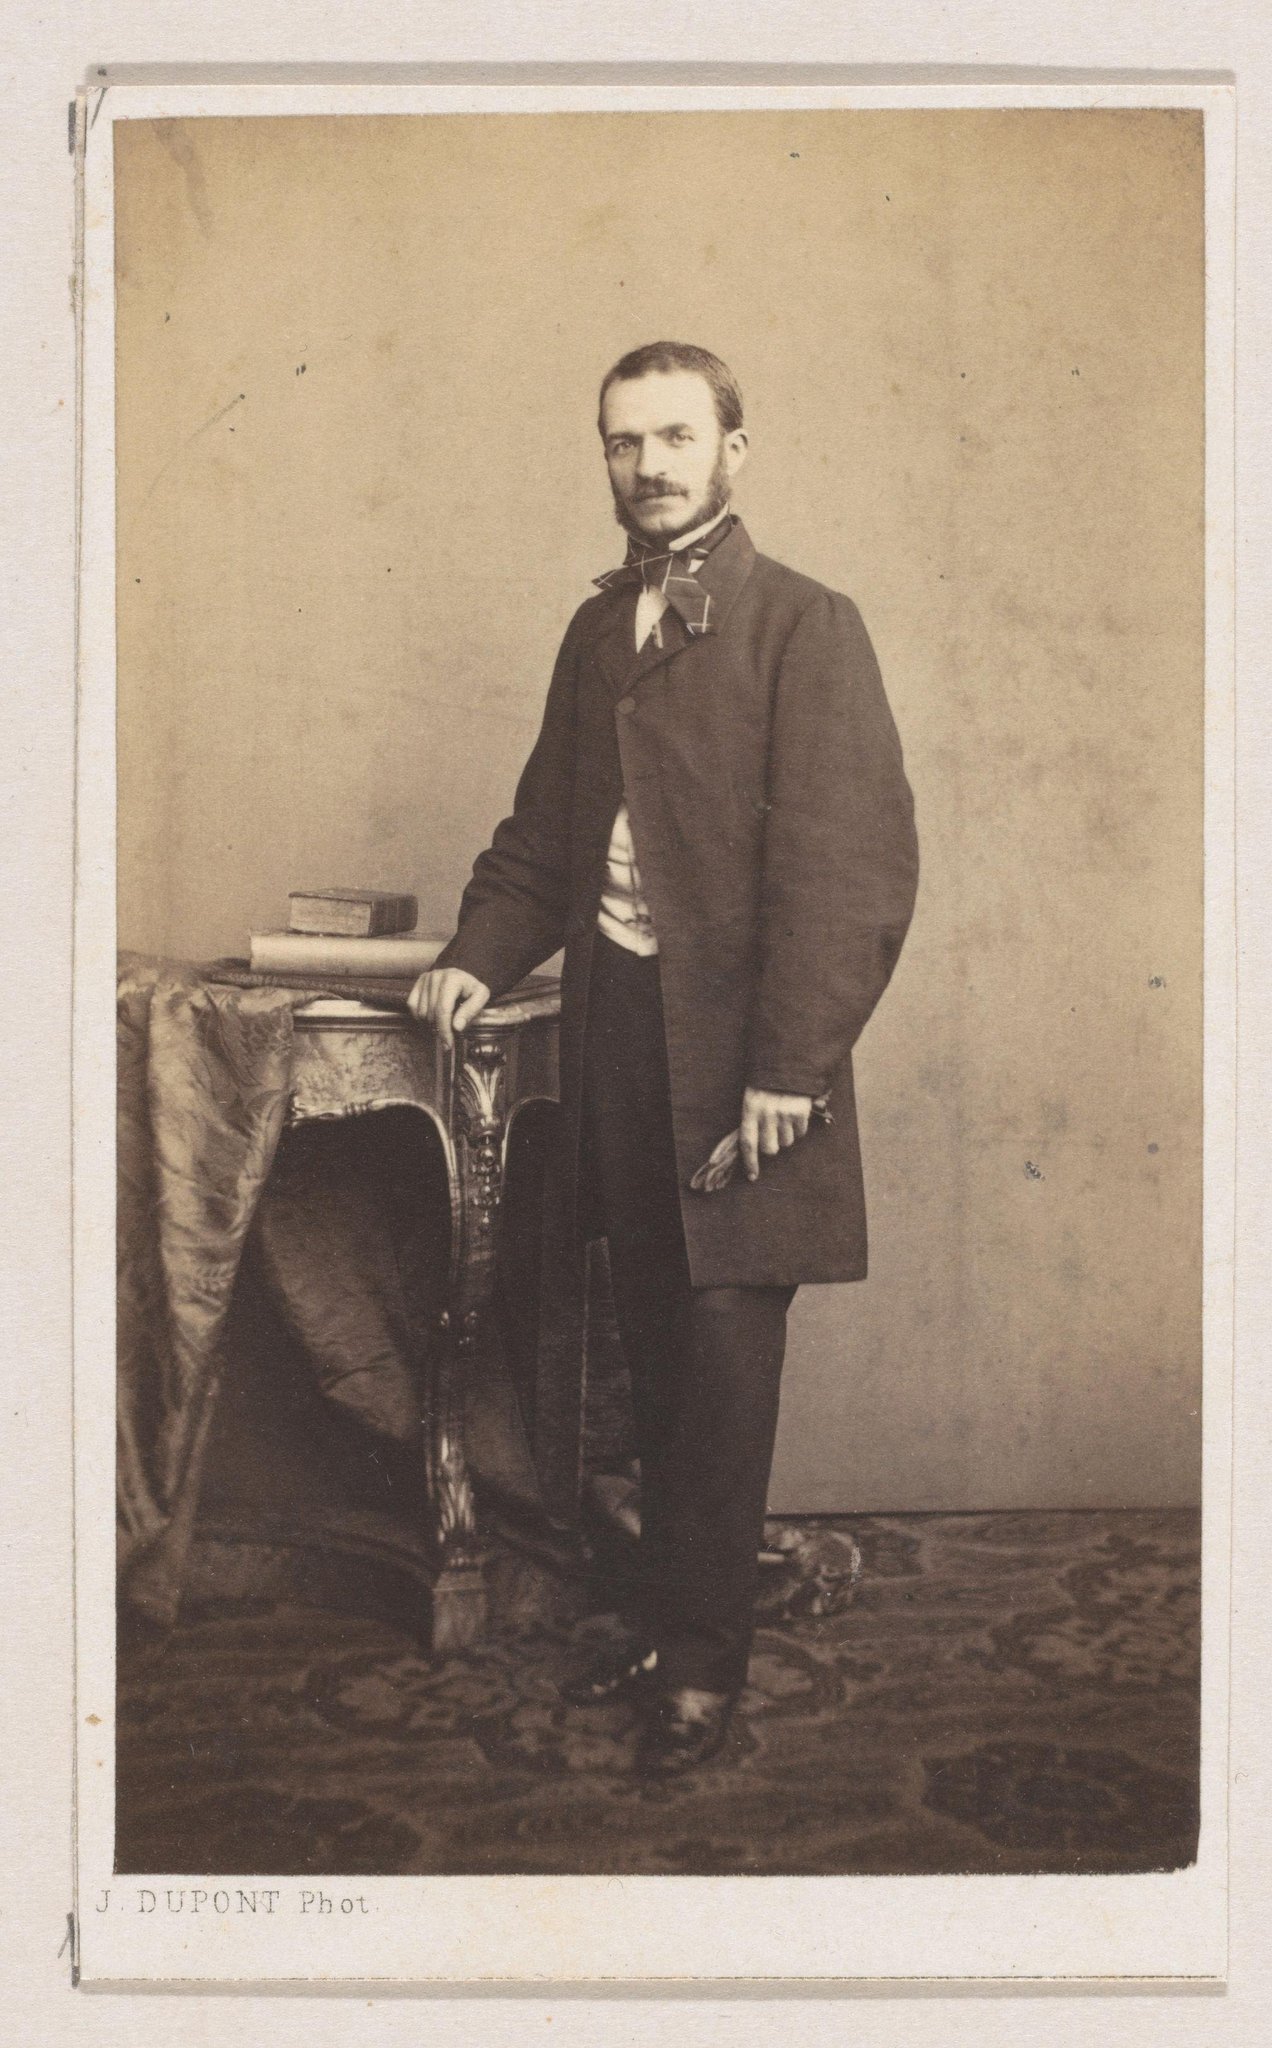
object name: photograph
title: L'École d'Anvers. Portraits biographies cartes de visite. Collection Dupont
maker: joseph dupont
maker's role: fotograaf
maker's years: 1818-1901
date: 1861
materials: cardboard, paper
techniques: albumen print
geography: antwerp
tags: print maker, historical persons, portrait, self-portrait of artist, portrait, self-portrait of draughtsman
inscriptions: inscription: ‘Verzwijvel’, inscription: ‘ETABLISSEMENT PHOTOGRAPHIQUE/ de/ J. DUPONT/ Place de Meir 32/ ANVERS/ Maison fondée en 1853’